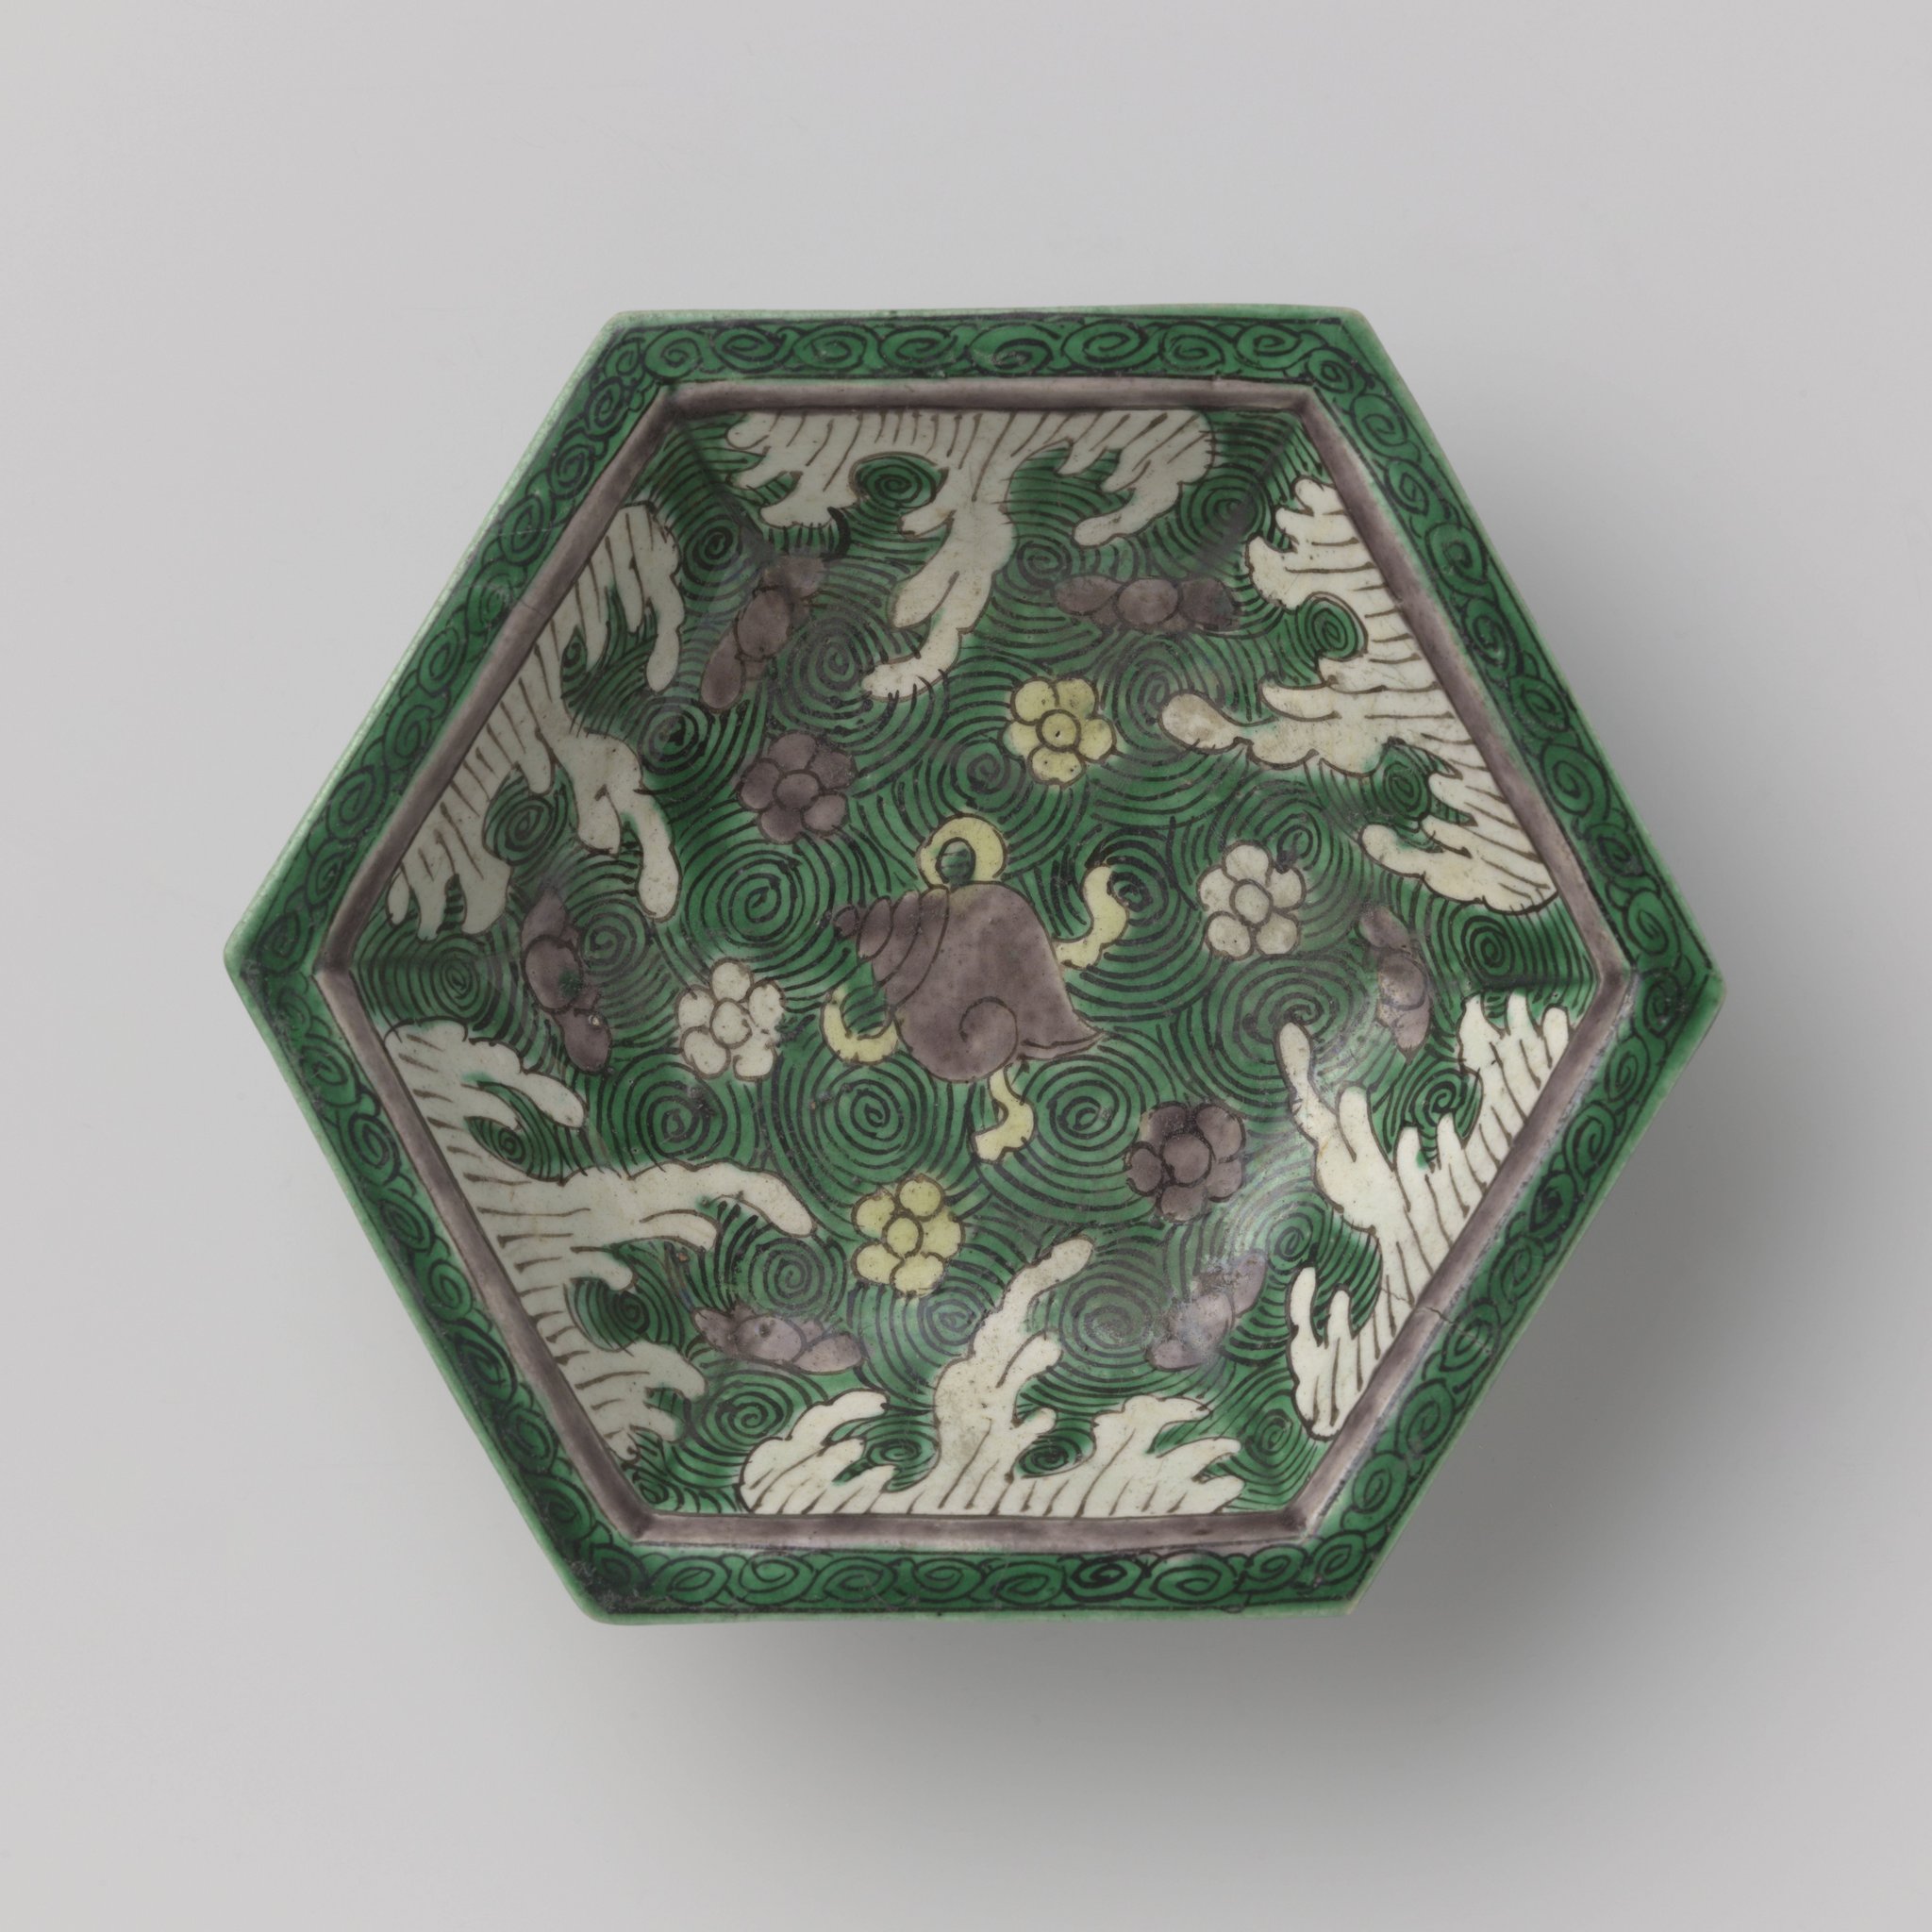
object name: bowl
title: Hexagonal bowl with precious objects on a green ground with cloud motifs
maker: Anonymous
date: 1875-1899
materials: cobalt, glaze, paint, porcelain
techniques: firing, forming, turning, vitrification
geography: china